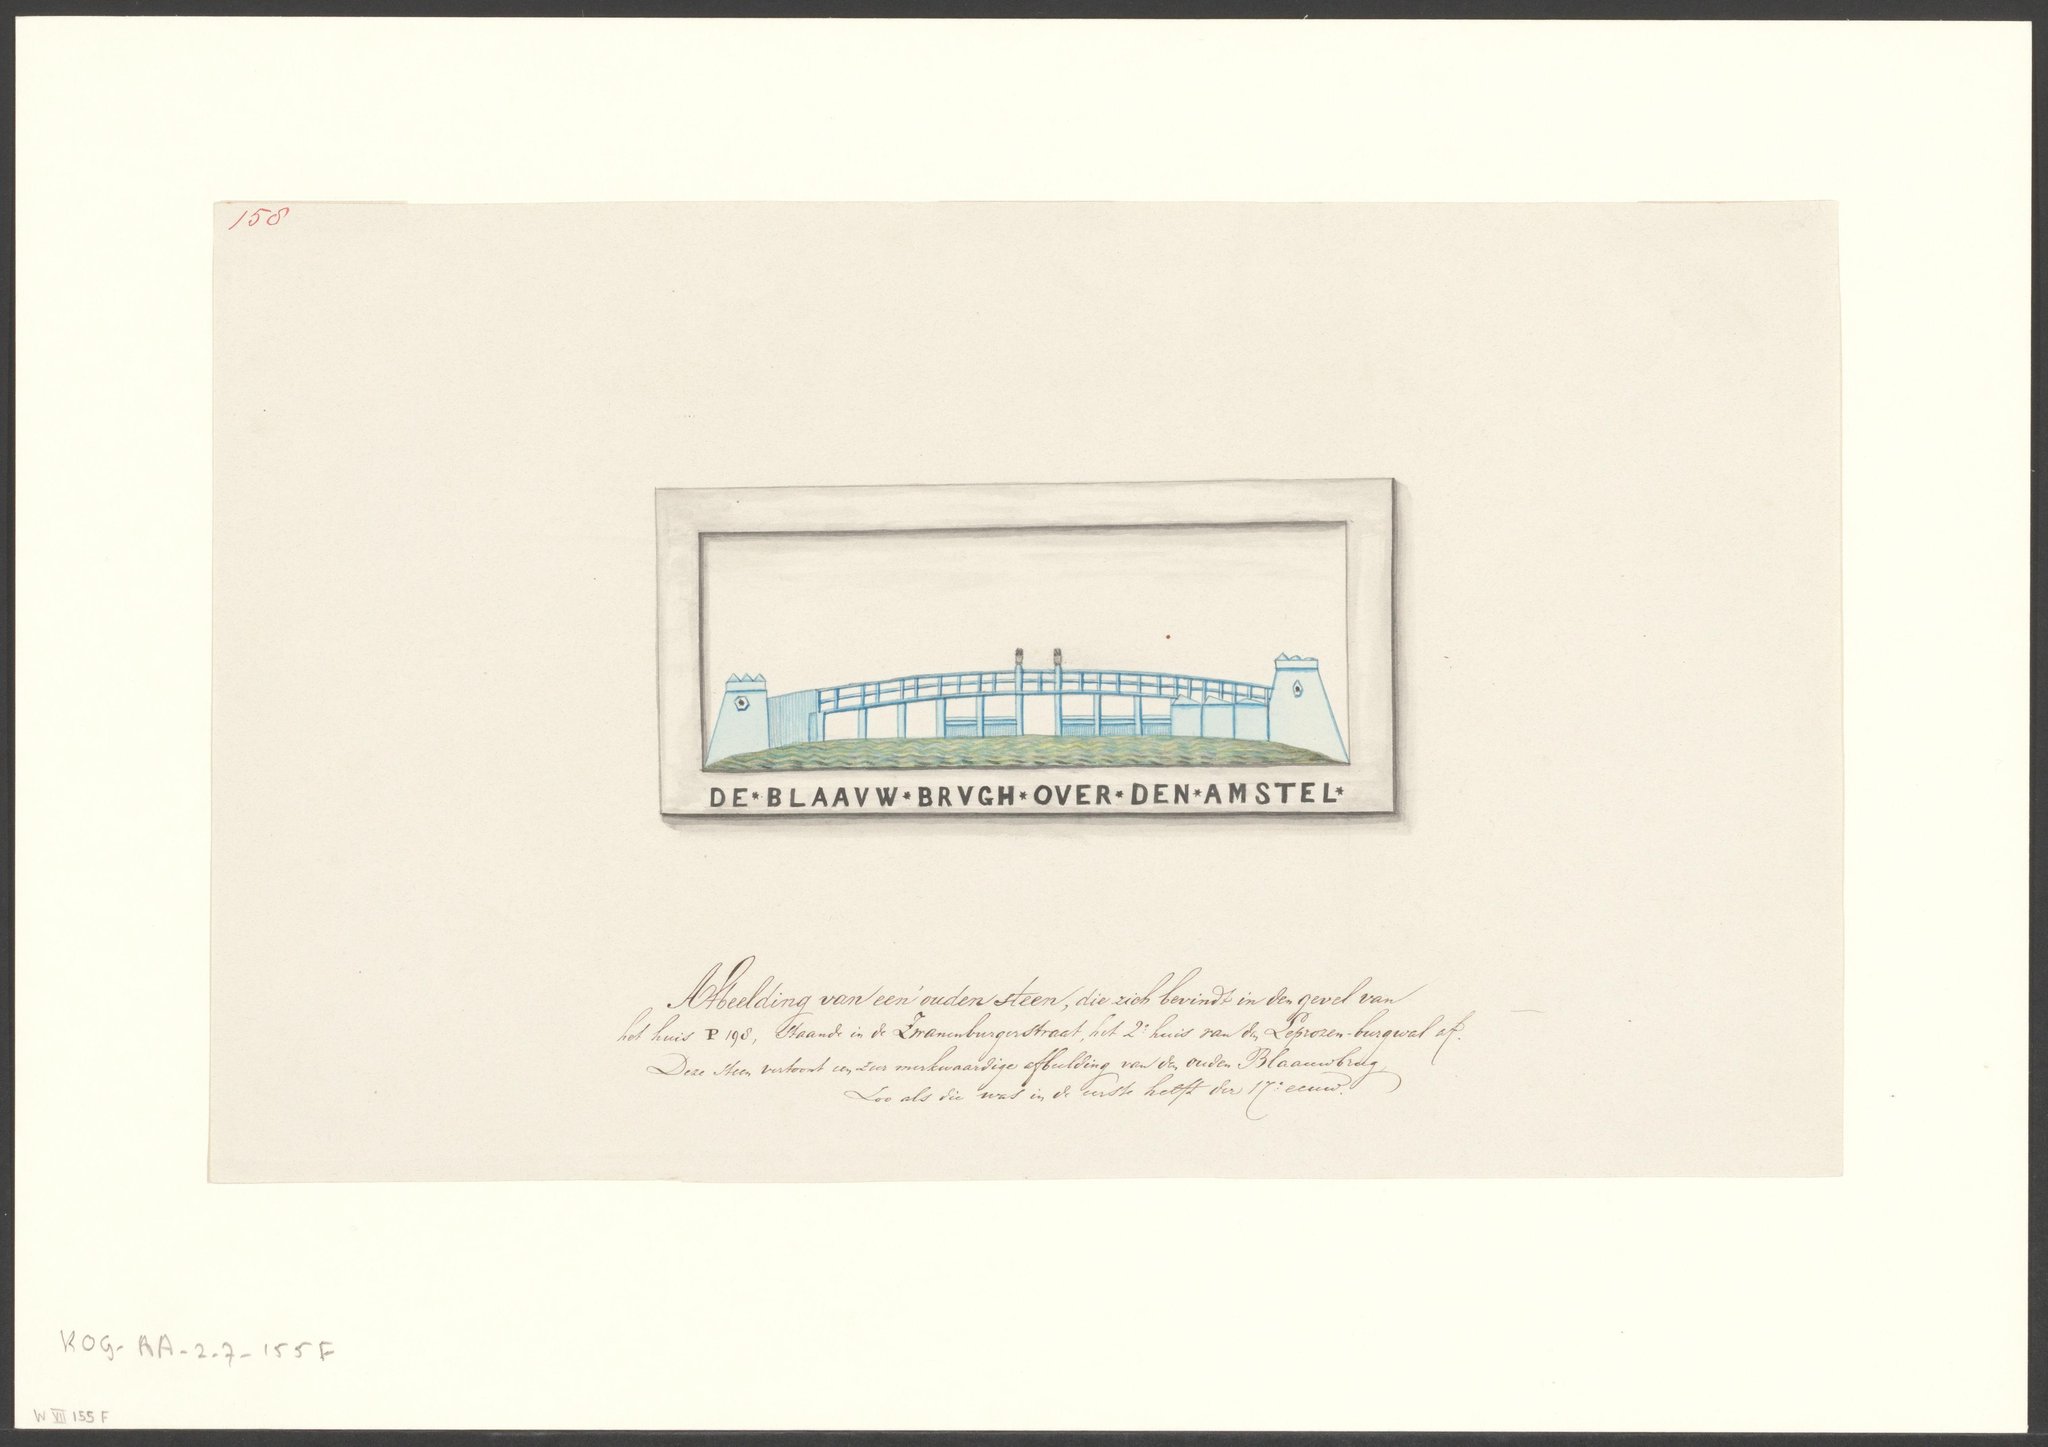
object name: drawing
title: Compositie met gevelsteen 'De Blaauwe brugh over den Amstel'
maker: Anonymous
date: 1750-1850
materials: paper, pencil, watercolor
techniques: brush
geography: amsterdam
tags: commemoration, jubilee, bridge in city across river, canal, etc.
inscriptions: inscription: ‘de*blaauw*brugh*over*den*amstel’, number: ‘158’, inscription: ‘Afbeelding van een (...) der 17e eeuw.’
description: Tekening binnen de Atlas Van Eck ingedeeld op wijknummer 7.